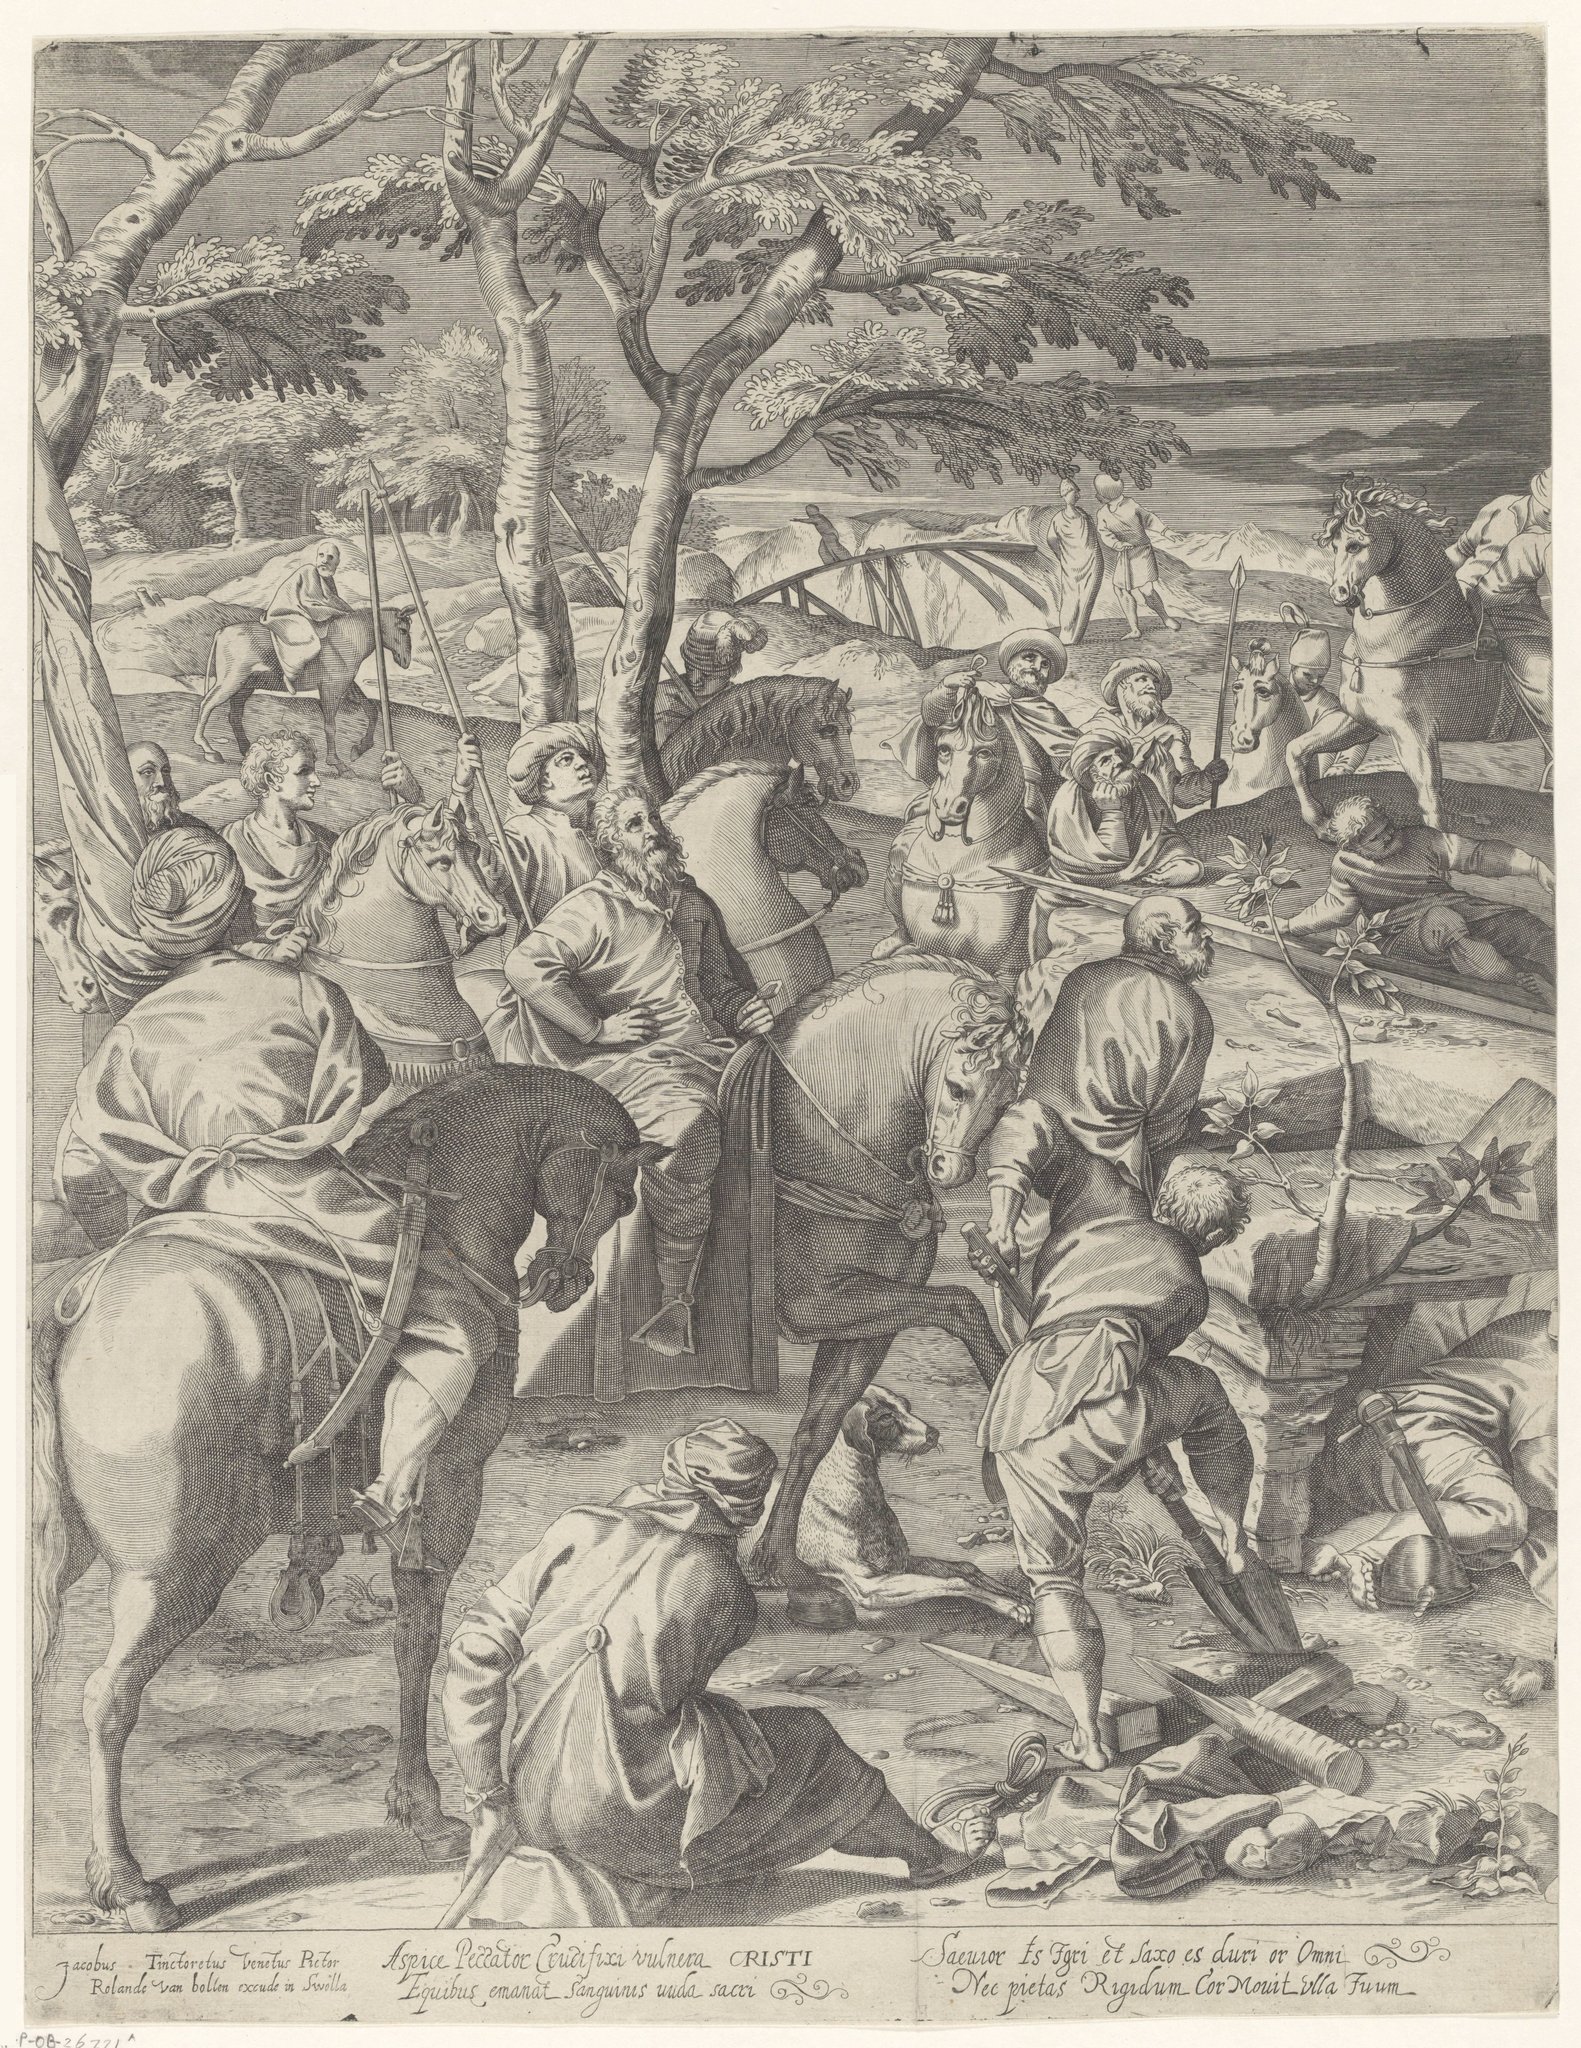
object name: print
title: Kruisiging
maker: roeland van bolten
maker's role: print maker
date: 1580-1608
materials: paper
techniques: engraving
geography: zwolle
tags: comprehensive representations of the events on golgotha during christ's hanging on the cross, no particular event emphasized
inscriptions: collector's mark: Lugt 2228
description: Linkerplaat van een prent waar Christus wordt gekruisigd op Golgota terwijl omstanders toekijken. Onder het kruis liggen Maria en Maria Magdalena, en enkele andere vrouwen. De misdadigers worden op hun kruisen genageld (Matteüs 27:38). Christus wordt een spons met zure wijn aangeboden (Matteüs 27:48). Linksonder het kruis dobbelen soldaten voor het kleed van Christus (Matteüs 27:35). Helemaal rechts wijst een centurio naar Christus (Lucas 23:47). De prent heeft een Latijns onderschrift.